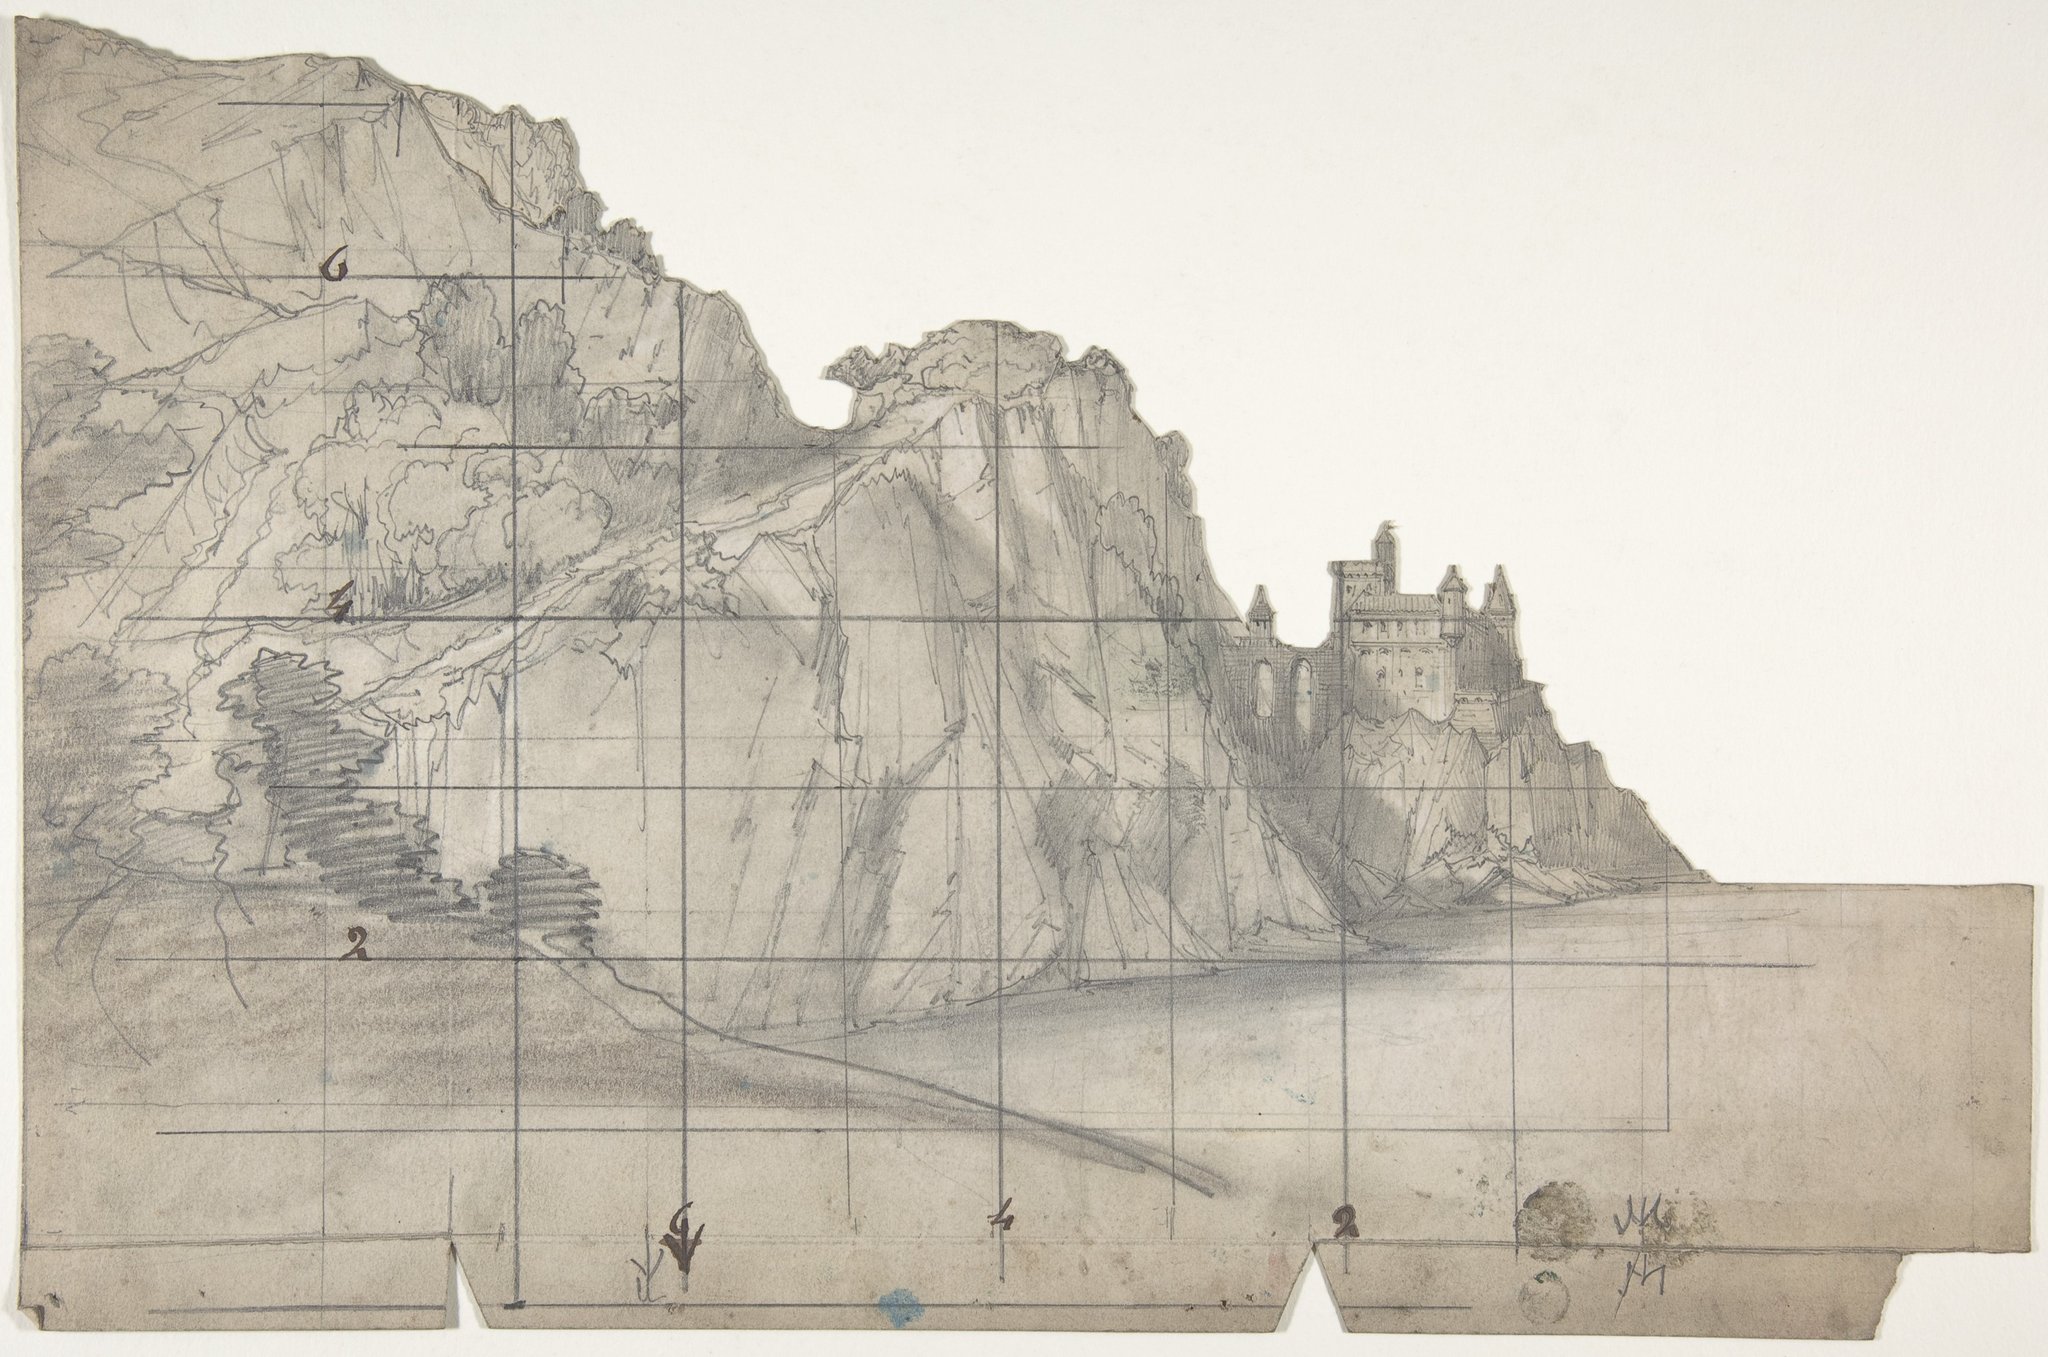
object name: drawing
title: Design for a Stage Set at the Opéra, Paris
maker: eugène cicéri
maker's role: artist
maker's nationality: french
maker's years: 1813-1890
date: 1830-1890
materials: graphite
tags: landscapes,stage design